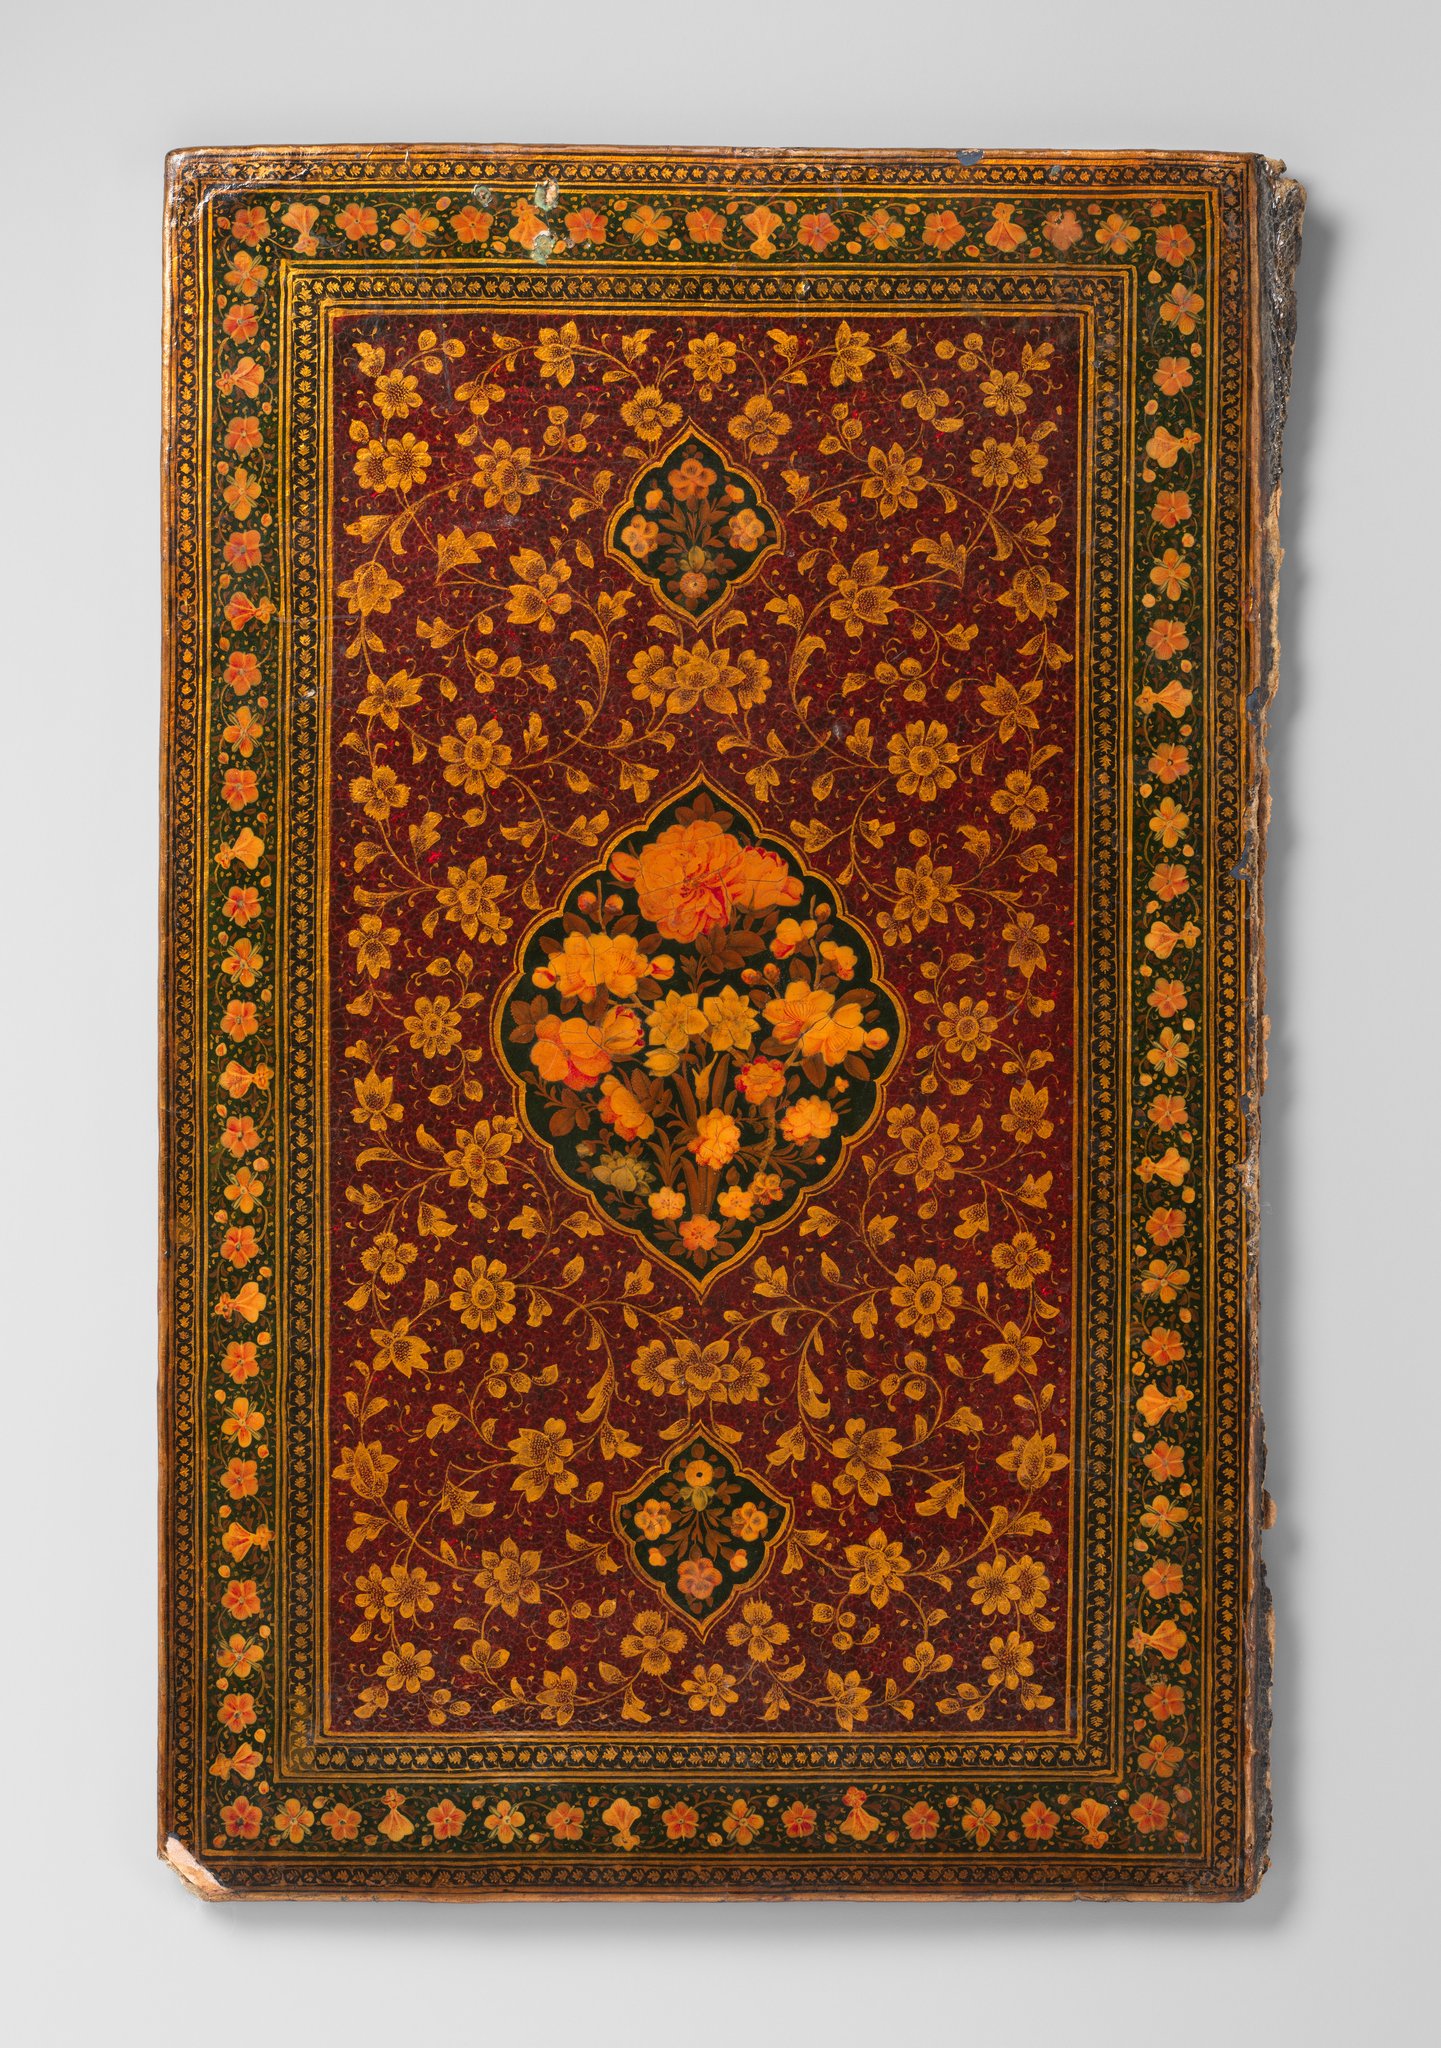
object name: bookbinding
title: Bookbinding (Jild-i kitab)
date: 1767-1833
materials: board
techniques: lacquer, painting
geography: iran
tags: flowers